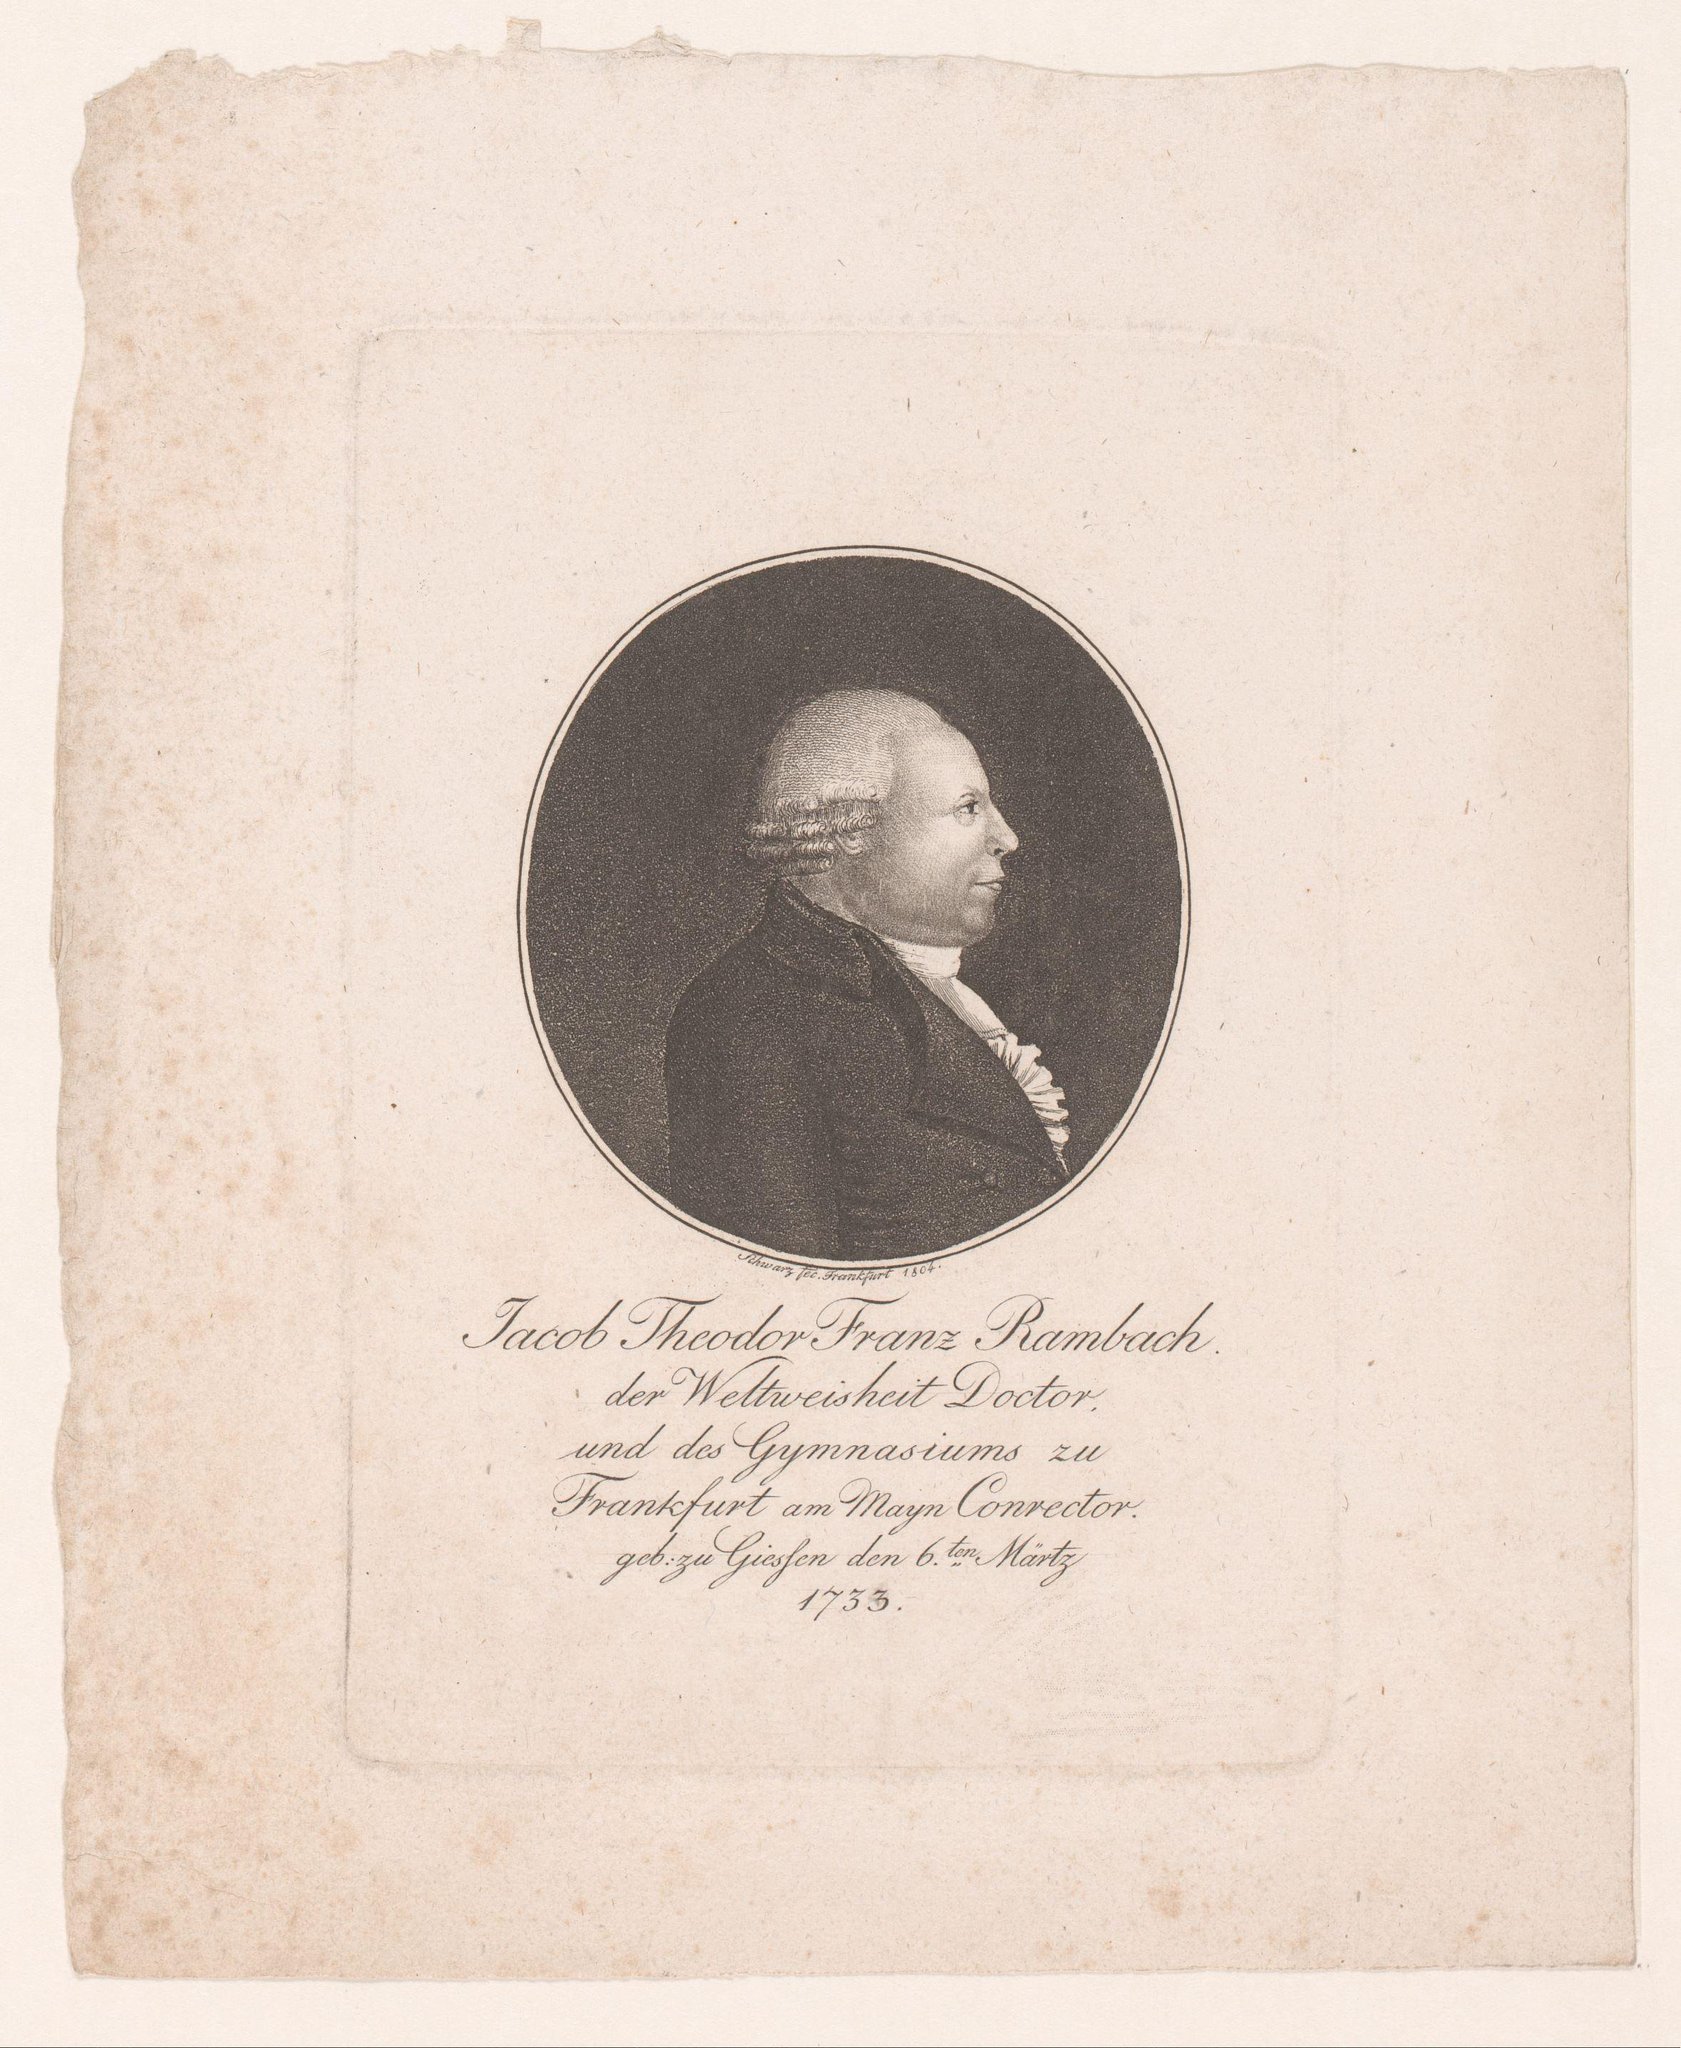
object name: print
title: Portret van Jakob Theodor Franz Rambach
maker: paul wolfgang schwarz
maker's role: print maker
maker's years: -1815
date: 1804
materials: paper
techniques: etching, engraving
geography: frankfurt am main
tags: historical persons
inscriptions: collector's mark: Lugt 2228